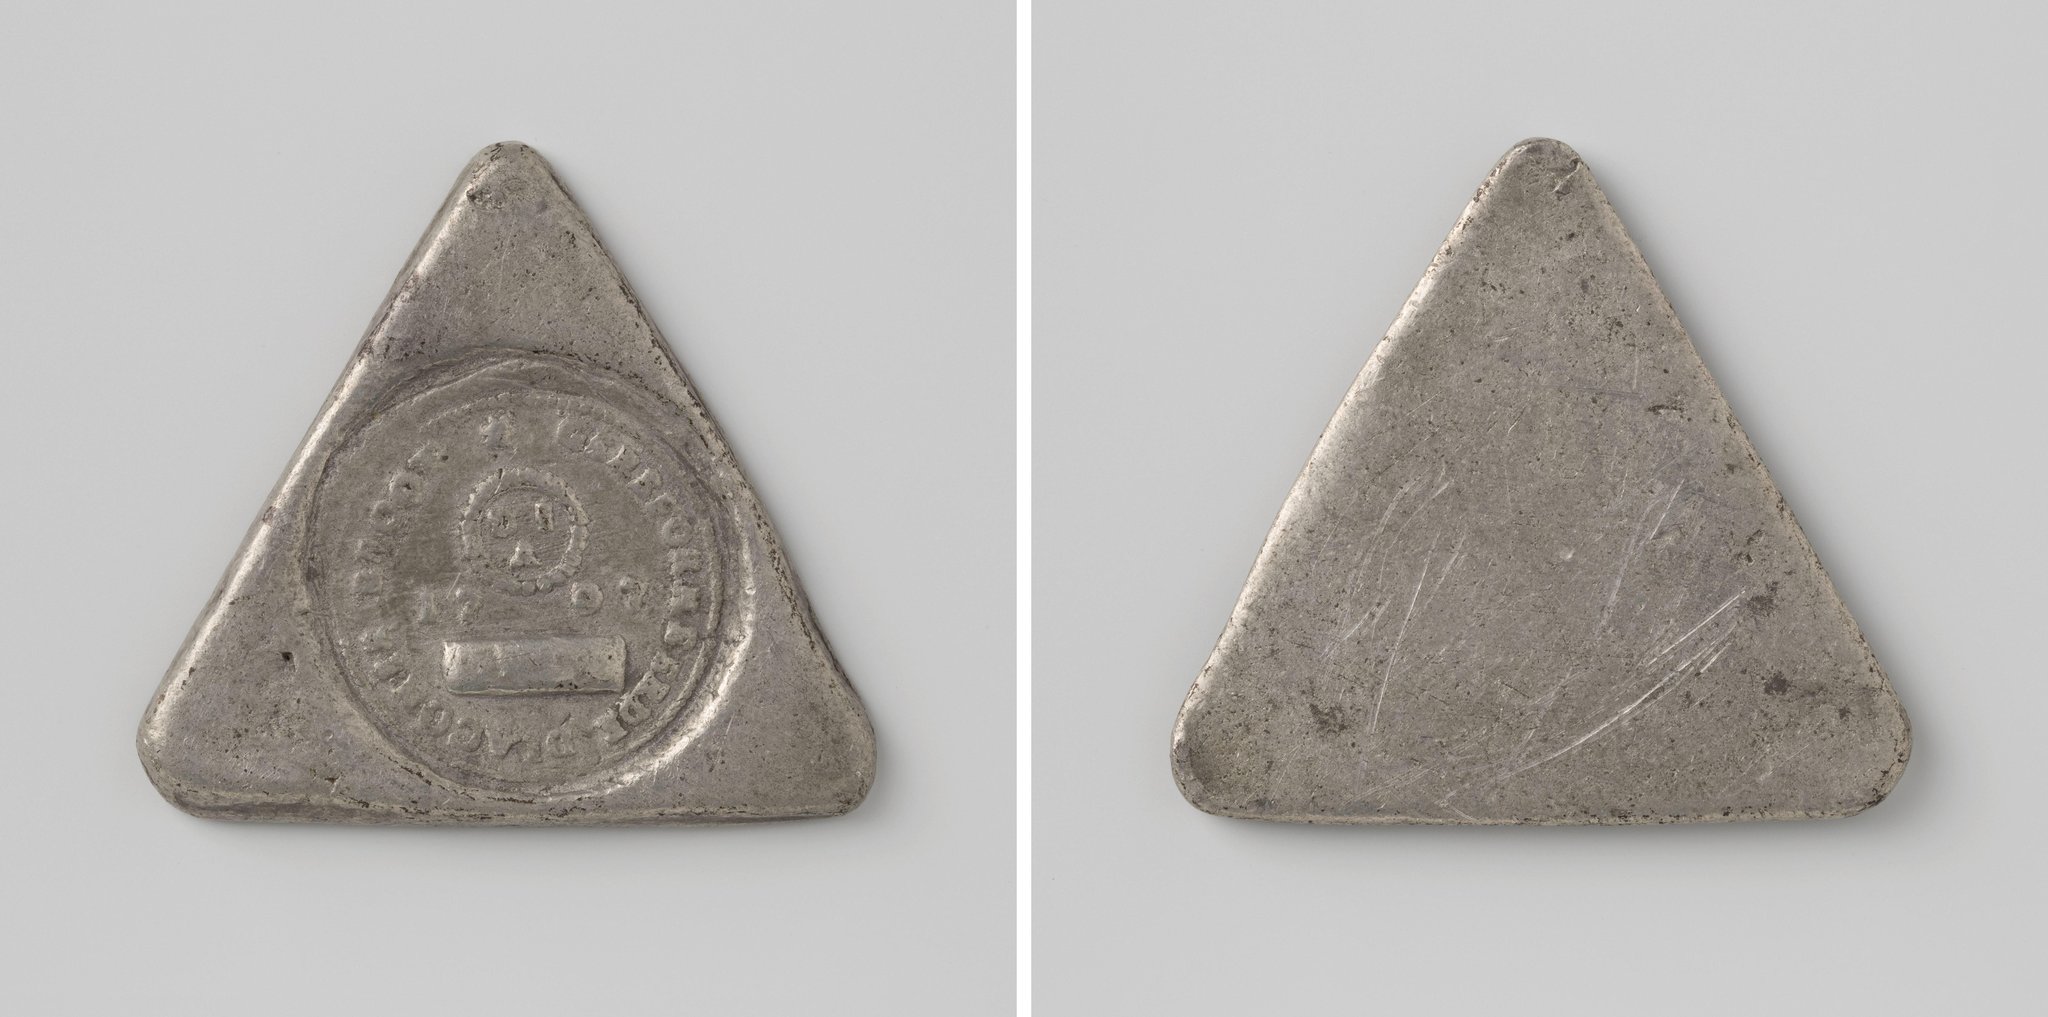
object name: alms token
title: Broodpenning van de Gereformeerde Diaconie te Amsterdam 1707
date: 1707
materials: lead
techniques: printing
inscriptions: circumscription: ‘(ster) GEREFORMEERDE DIACONIE BROOT’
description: Dik driehoekig stukje lood, met eenzijdig een ronde instempeling waarop een krans met DIA, het jaartal 1707 en een brood, met omschrift